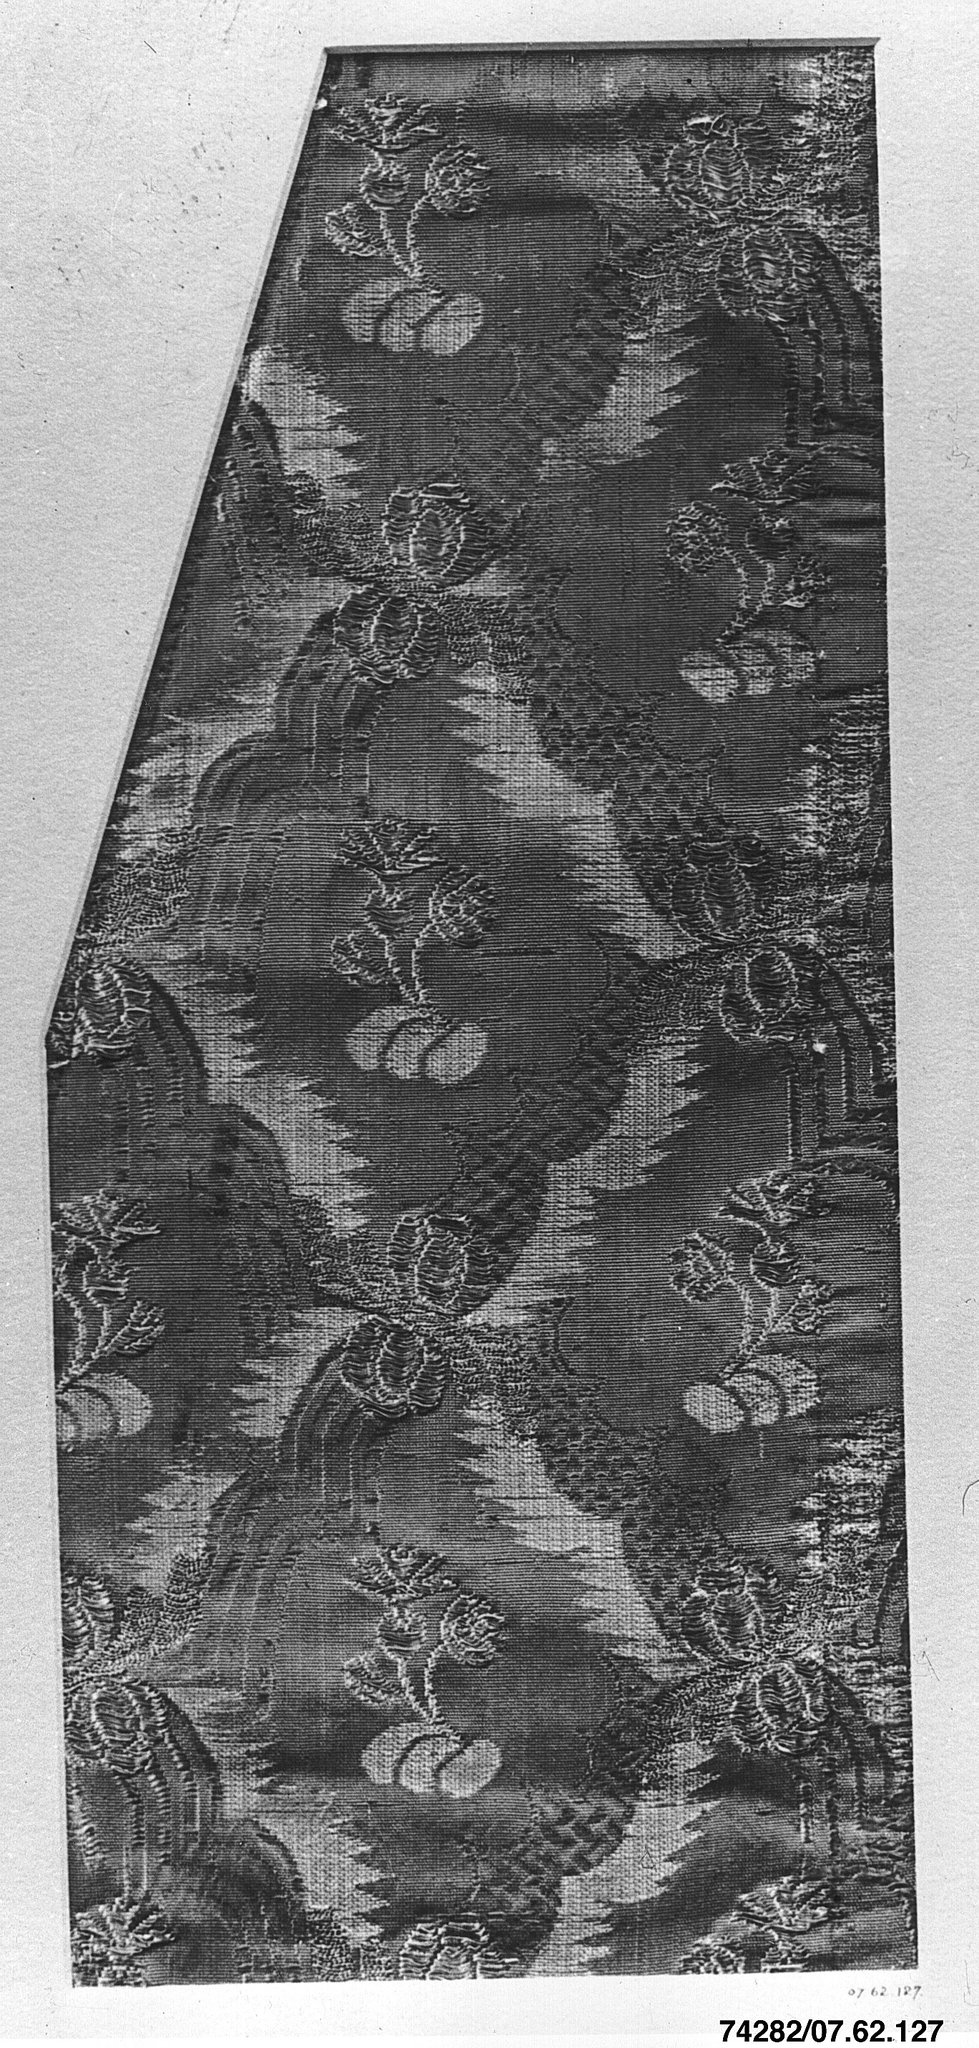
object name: piece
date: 1767-1800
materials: metal thread, silk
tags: flowers,leaves